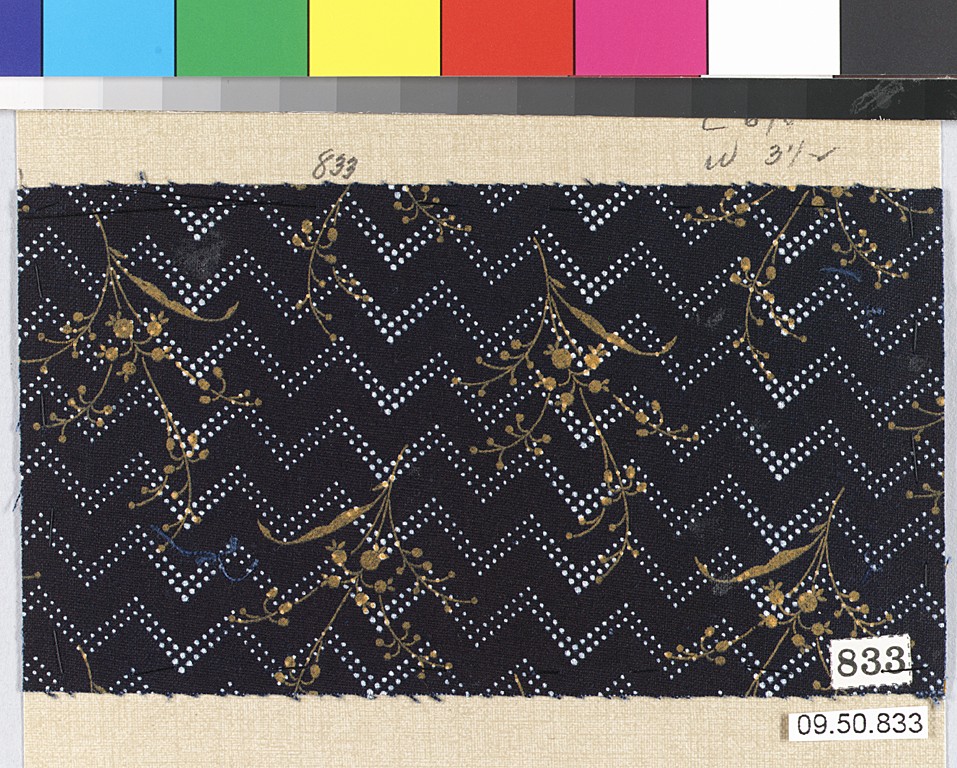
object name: piece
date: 1801-1900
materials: cotton